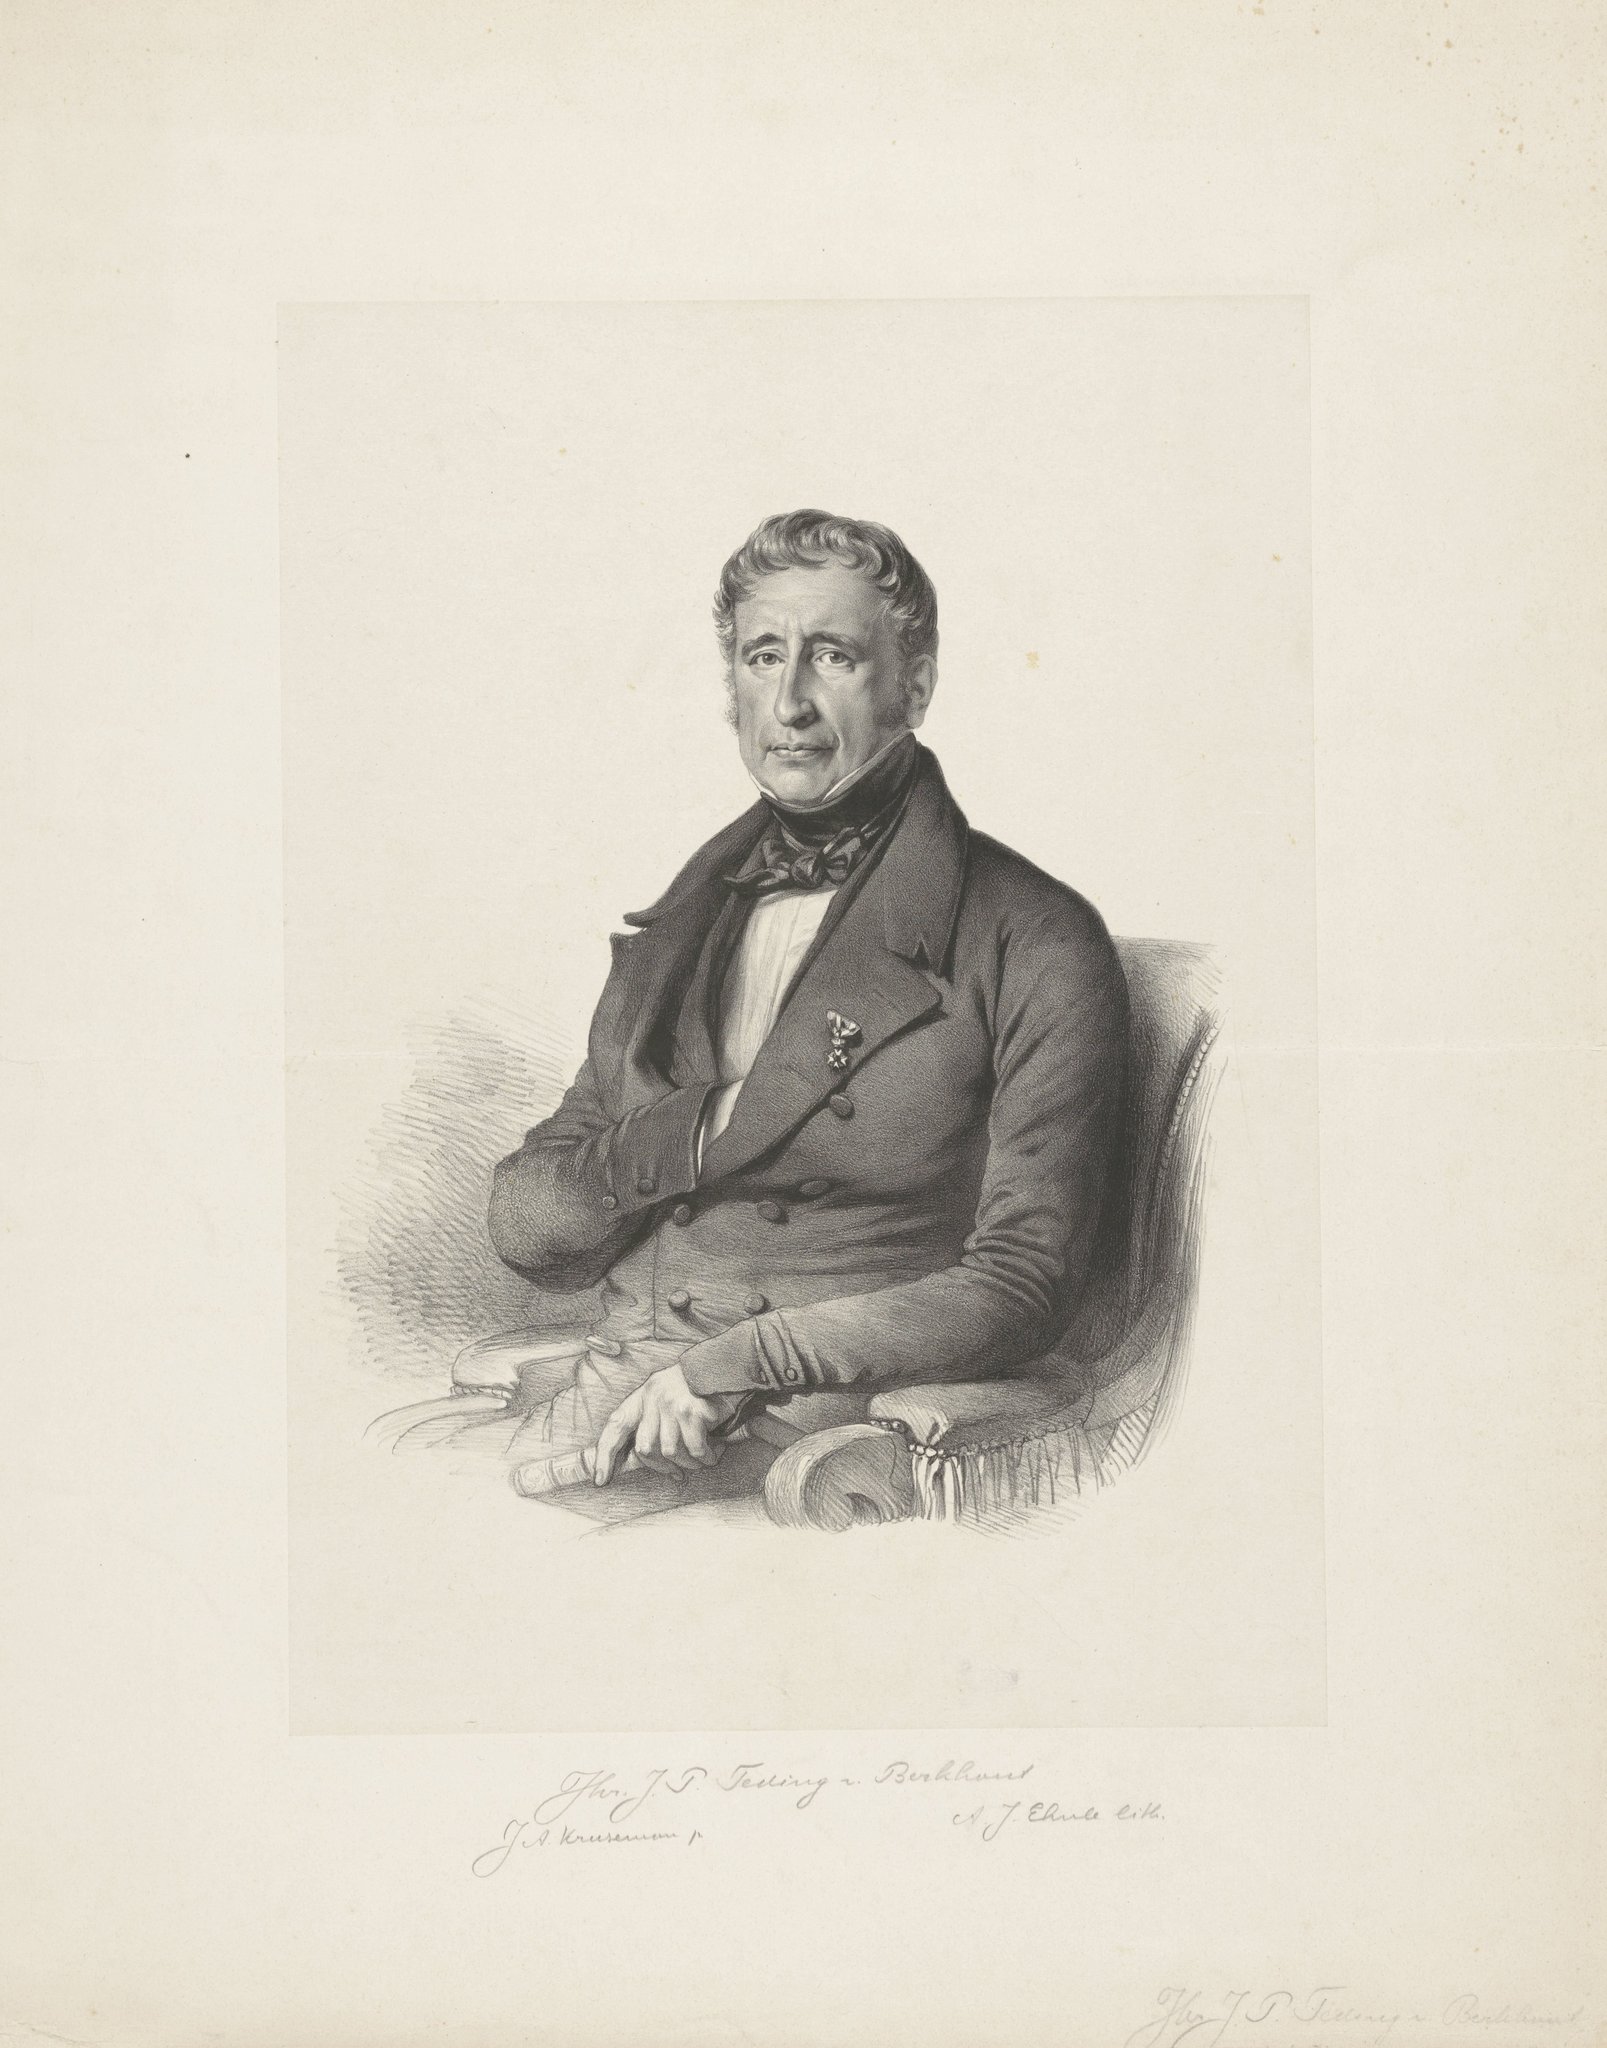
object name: print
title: Portret van Jan Pieter Teding van Berkhout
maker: adrianus johannes ehnle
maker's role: draughtsman, print maker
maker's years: 1819-1863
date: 1829-1863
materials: paper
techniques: lithograph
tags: politician, knighthood order, book, historical persons (+ (full) bust portrait)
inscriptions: collector's mark: Lugt 2228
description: De geportretteerde zit in een stoel en heeft zijn rechterhand in zijn jas gestoken. In zijn linkerhand heeft hij een boek. Hij draagt een ridderorde op de revers van zijn jas.